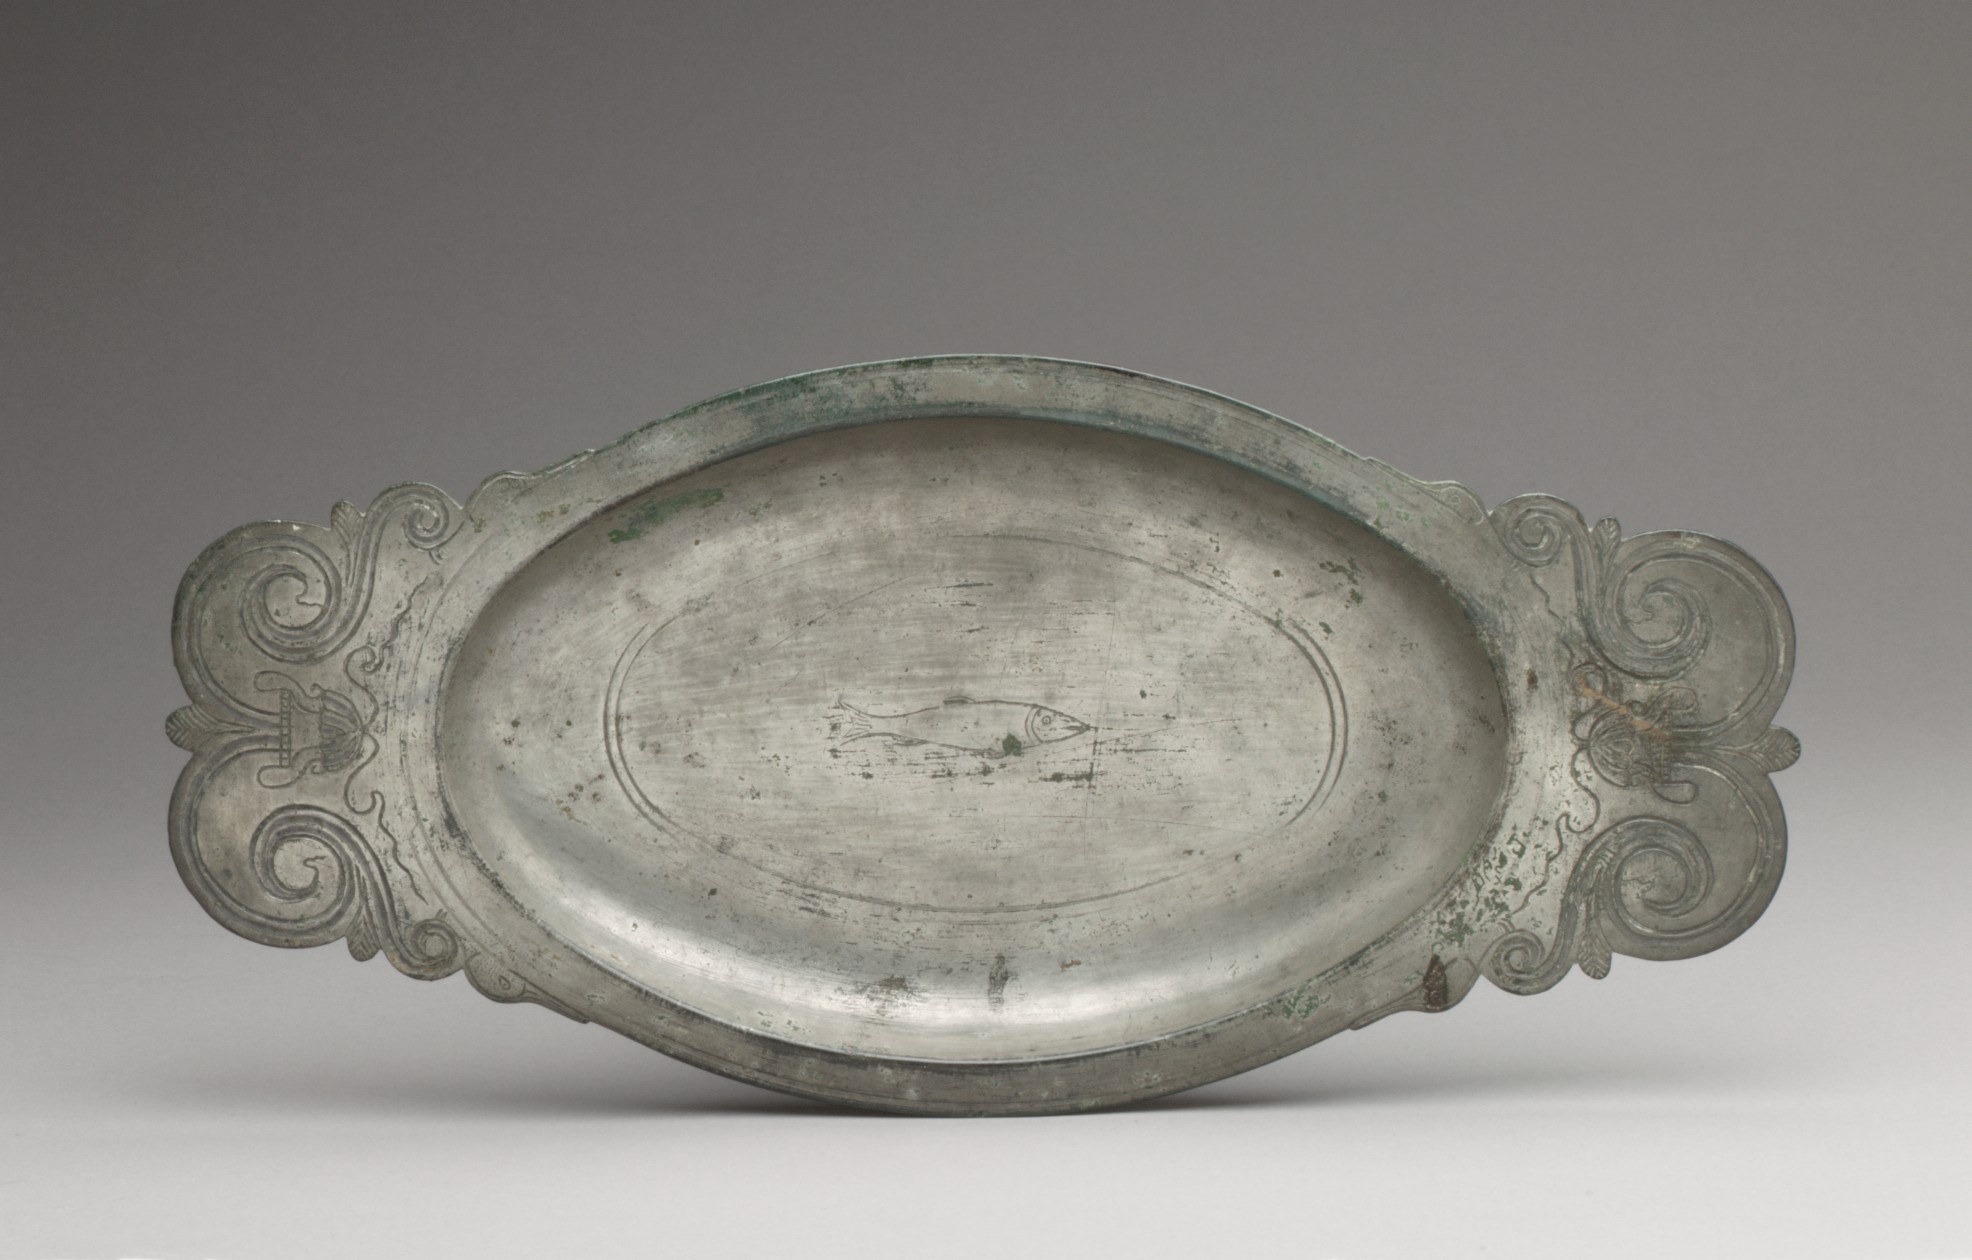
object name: platter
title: Platter with a Fish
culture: roman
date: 301-500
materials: bronze, silver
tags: fish